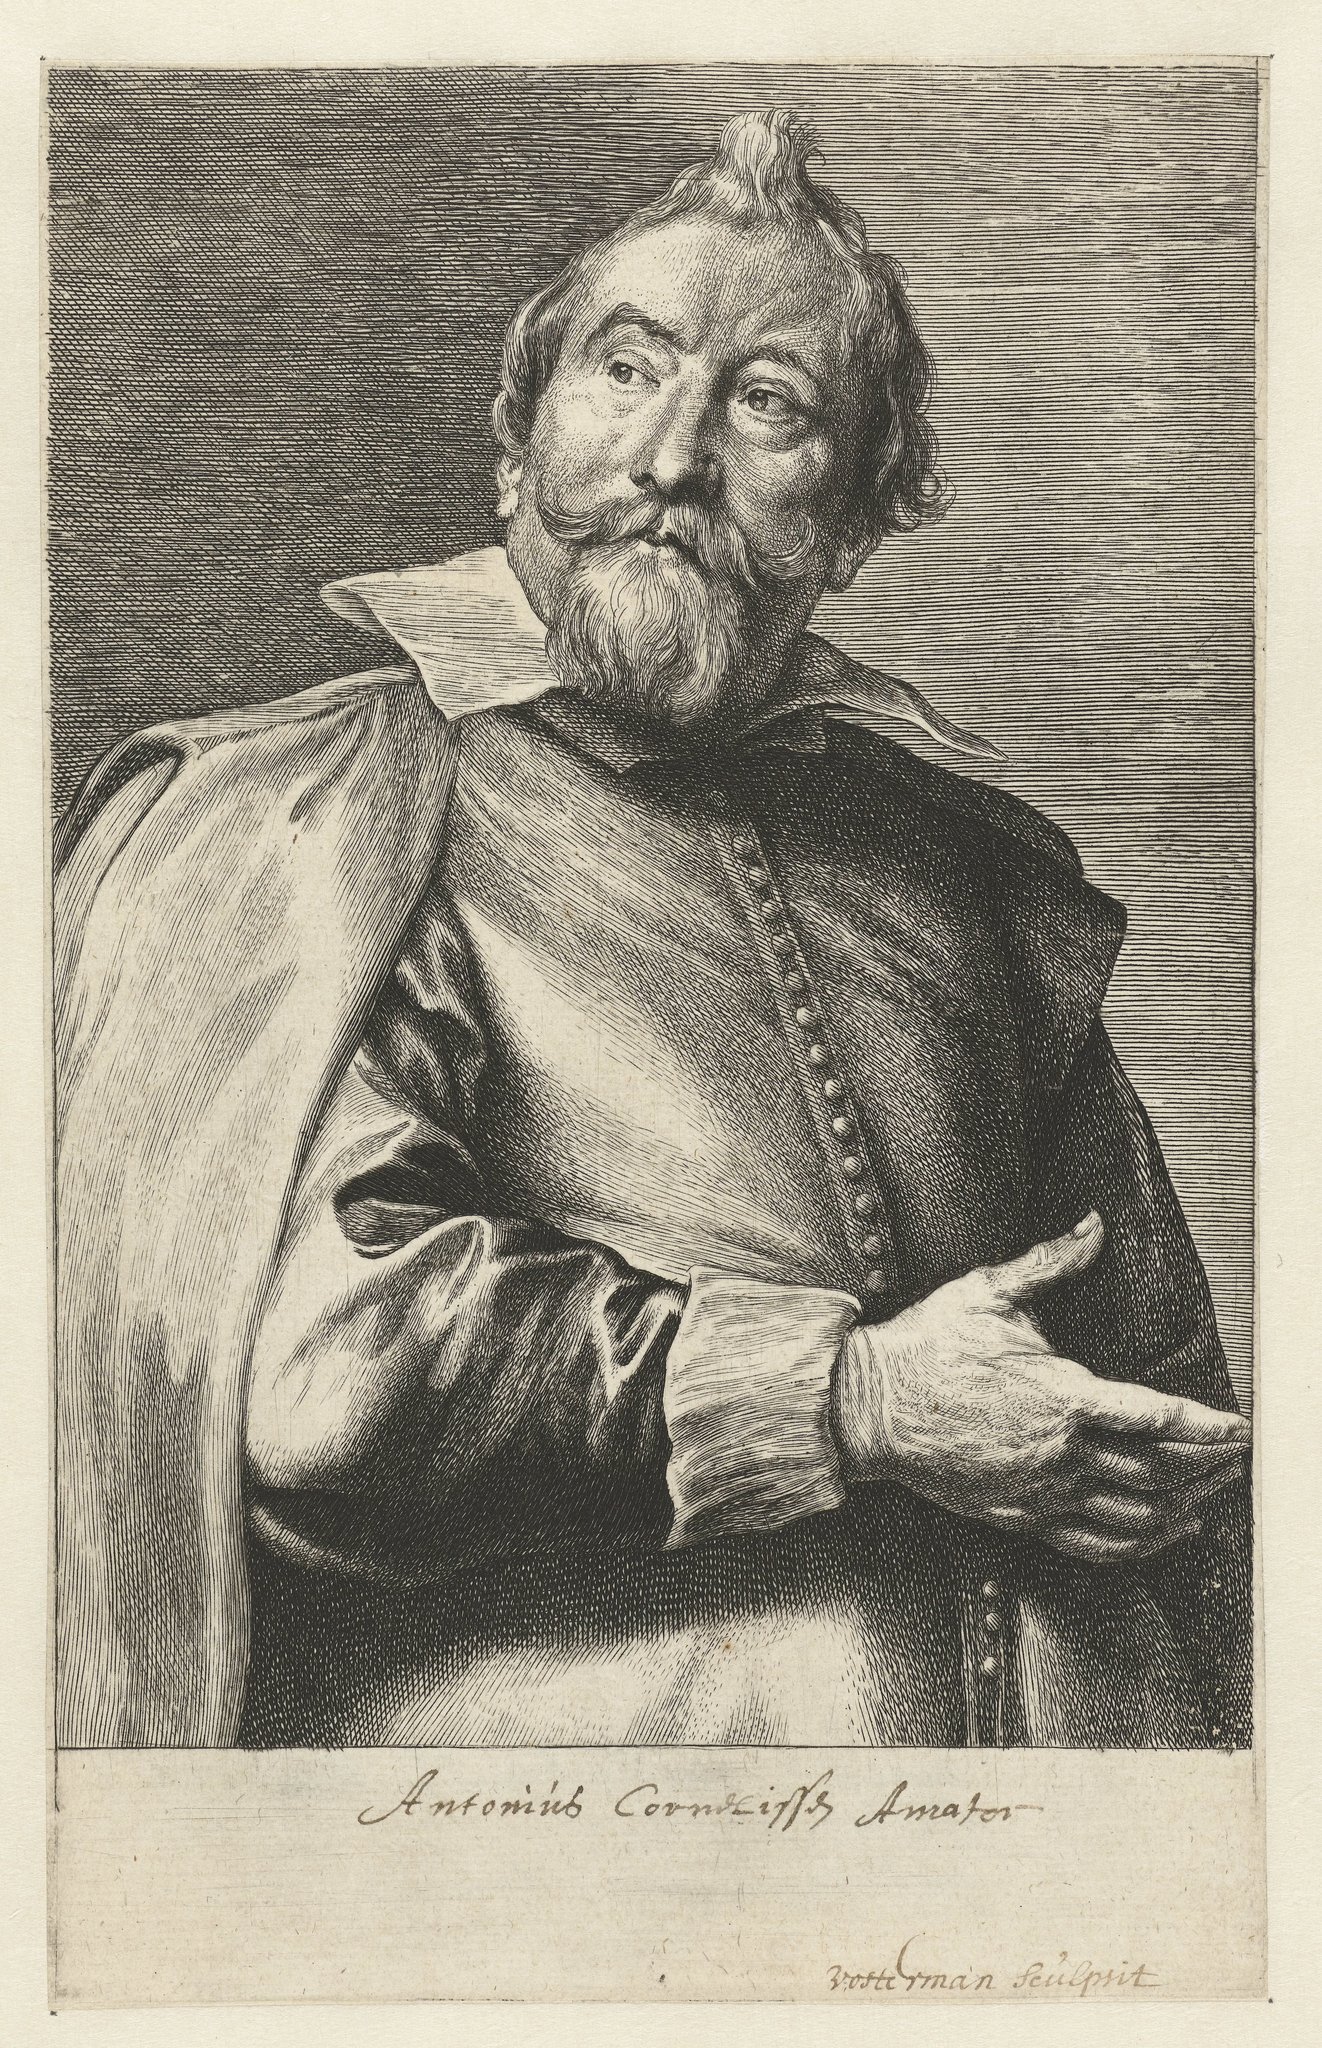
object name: print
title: Portret van de verzamelaar Antonius Cornelissen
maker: lucas vorsterman (i)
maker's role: print maker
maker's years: 1595-1675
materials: paper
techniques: engraving, etching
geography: low countries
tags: art collector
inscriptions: collector's mark: Lugt 240, inscription: ‘Antonius Cornelissen Amator’